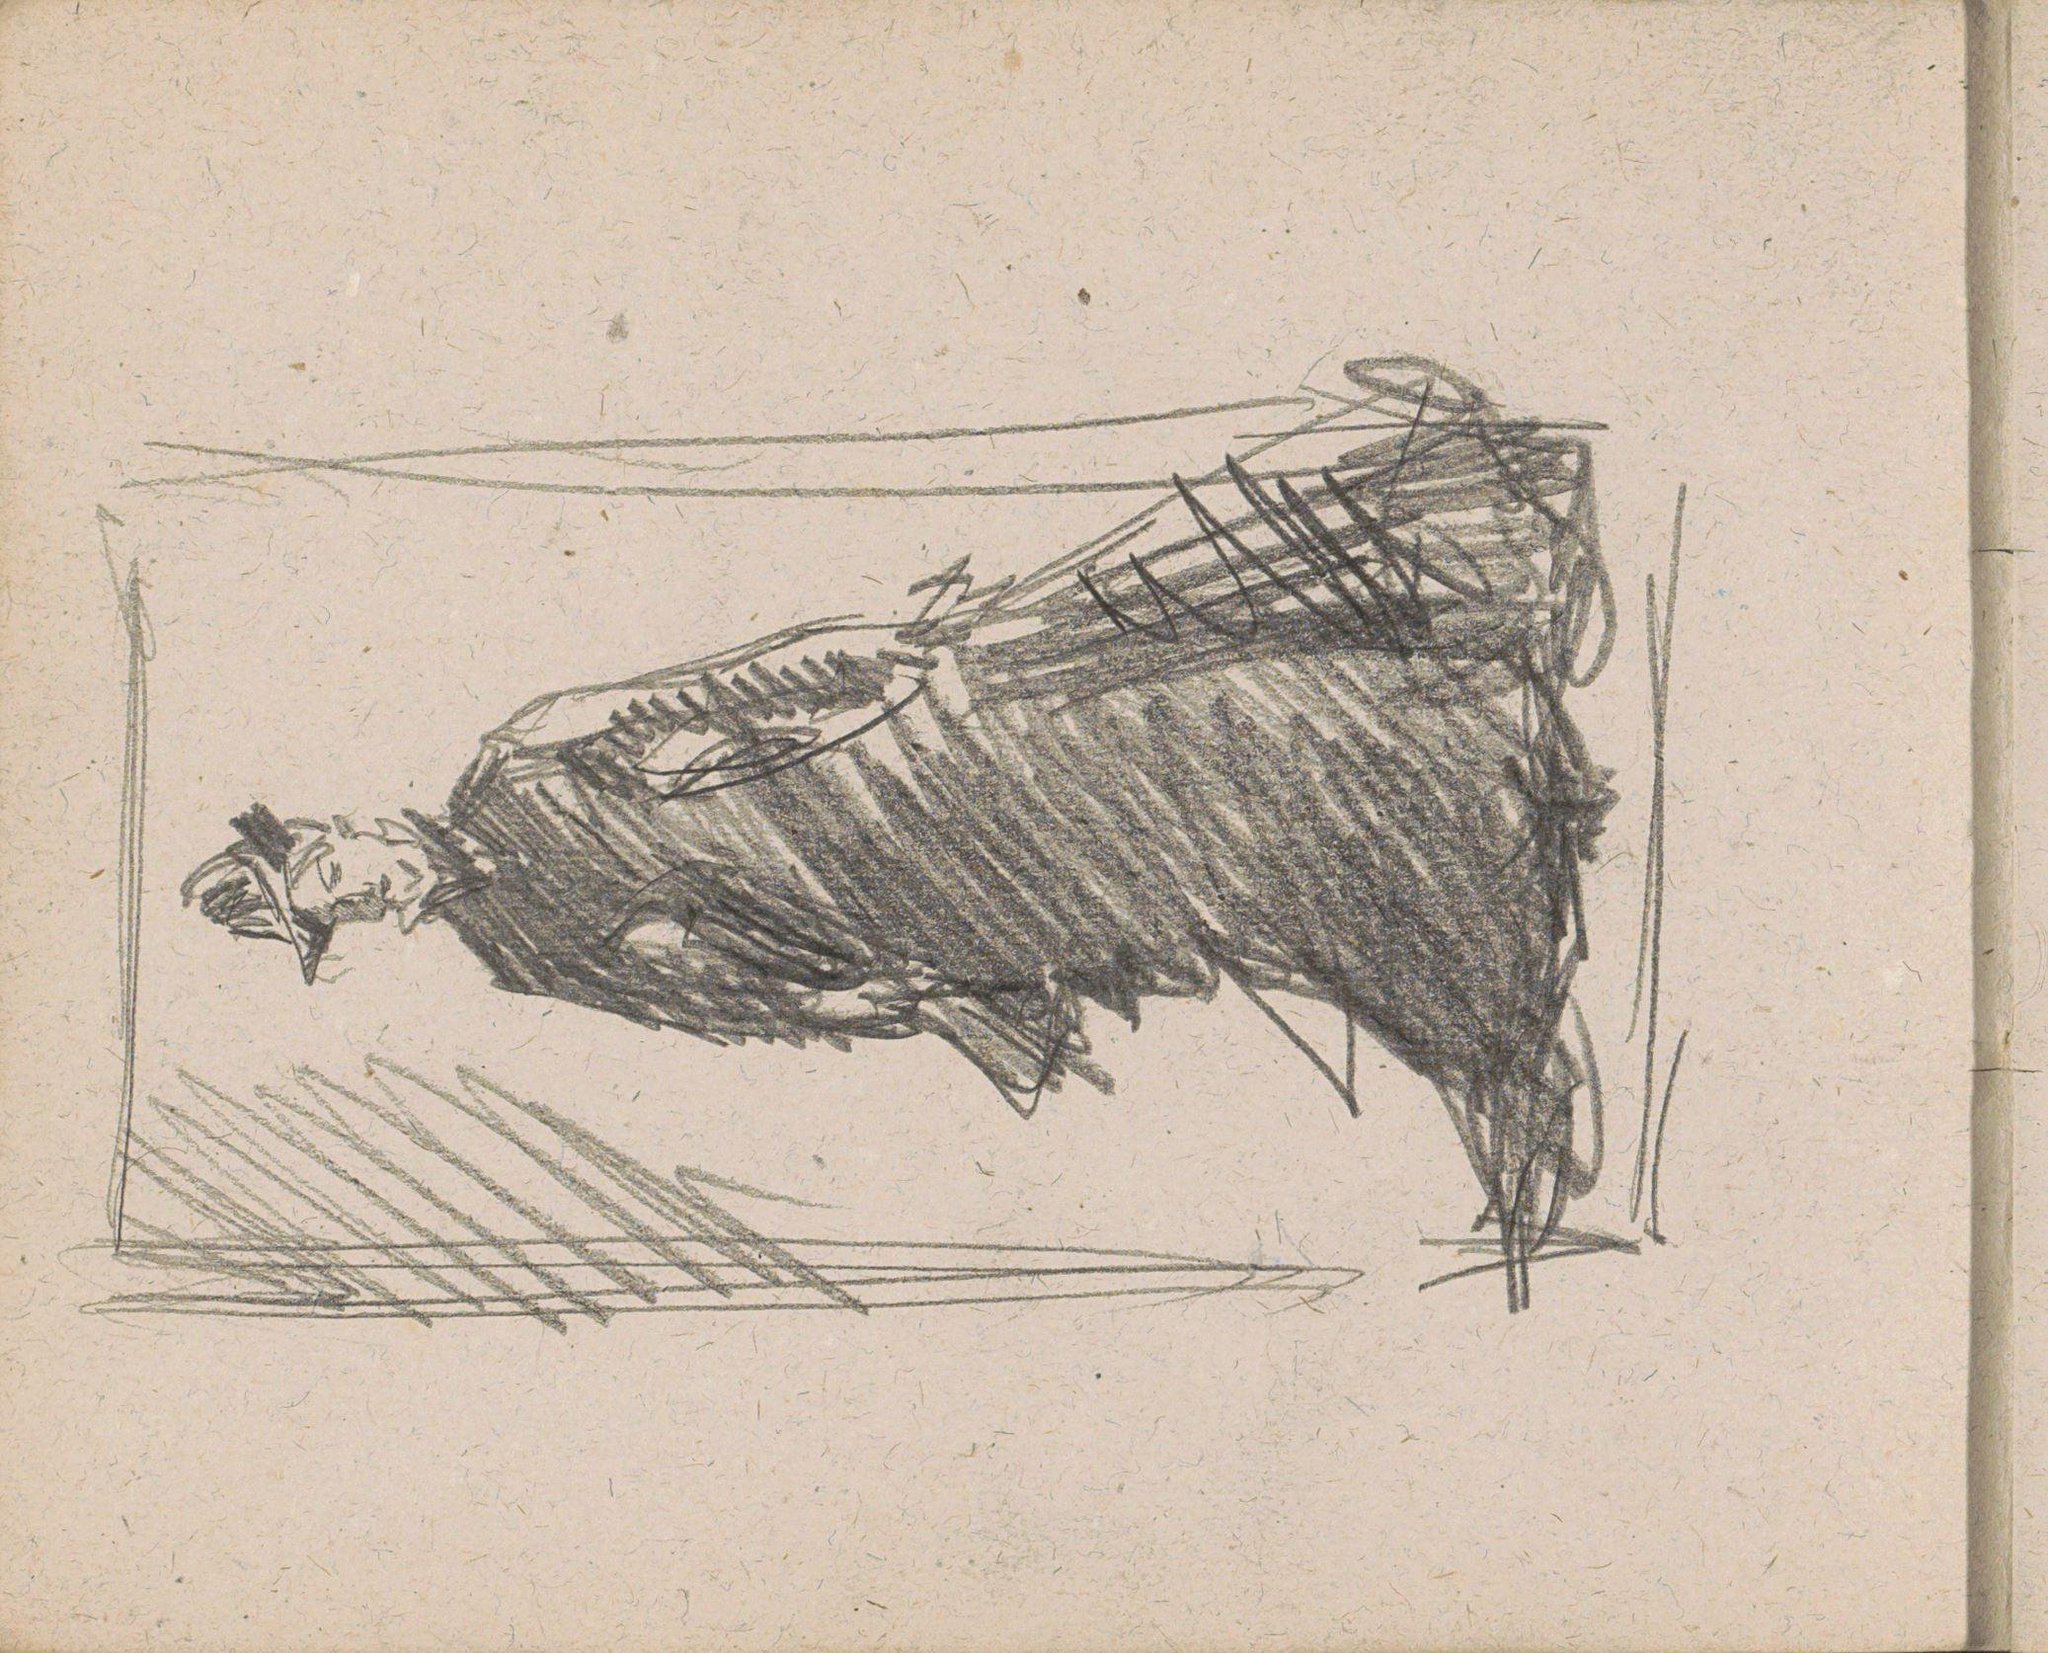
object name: sketchbook leaf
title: Portret van een onbekende vrouw, staand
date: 1919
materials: paper, pencil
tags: anonymous historical person portrayed alone - bb - woman, adult woman (+ standing), picture, painting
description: Mogelijk naar een schilderij dat zich in een Deense of Zweedse collectie bevindt. Pagina 11 uit schetsboek XXXV met 36 pagina's.